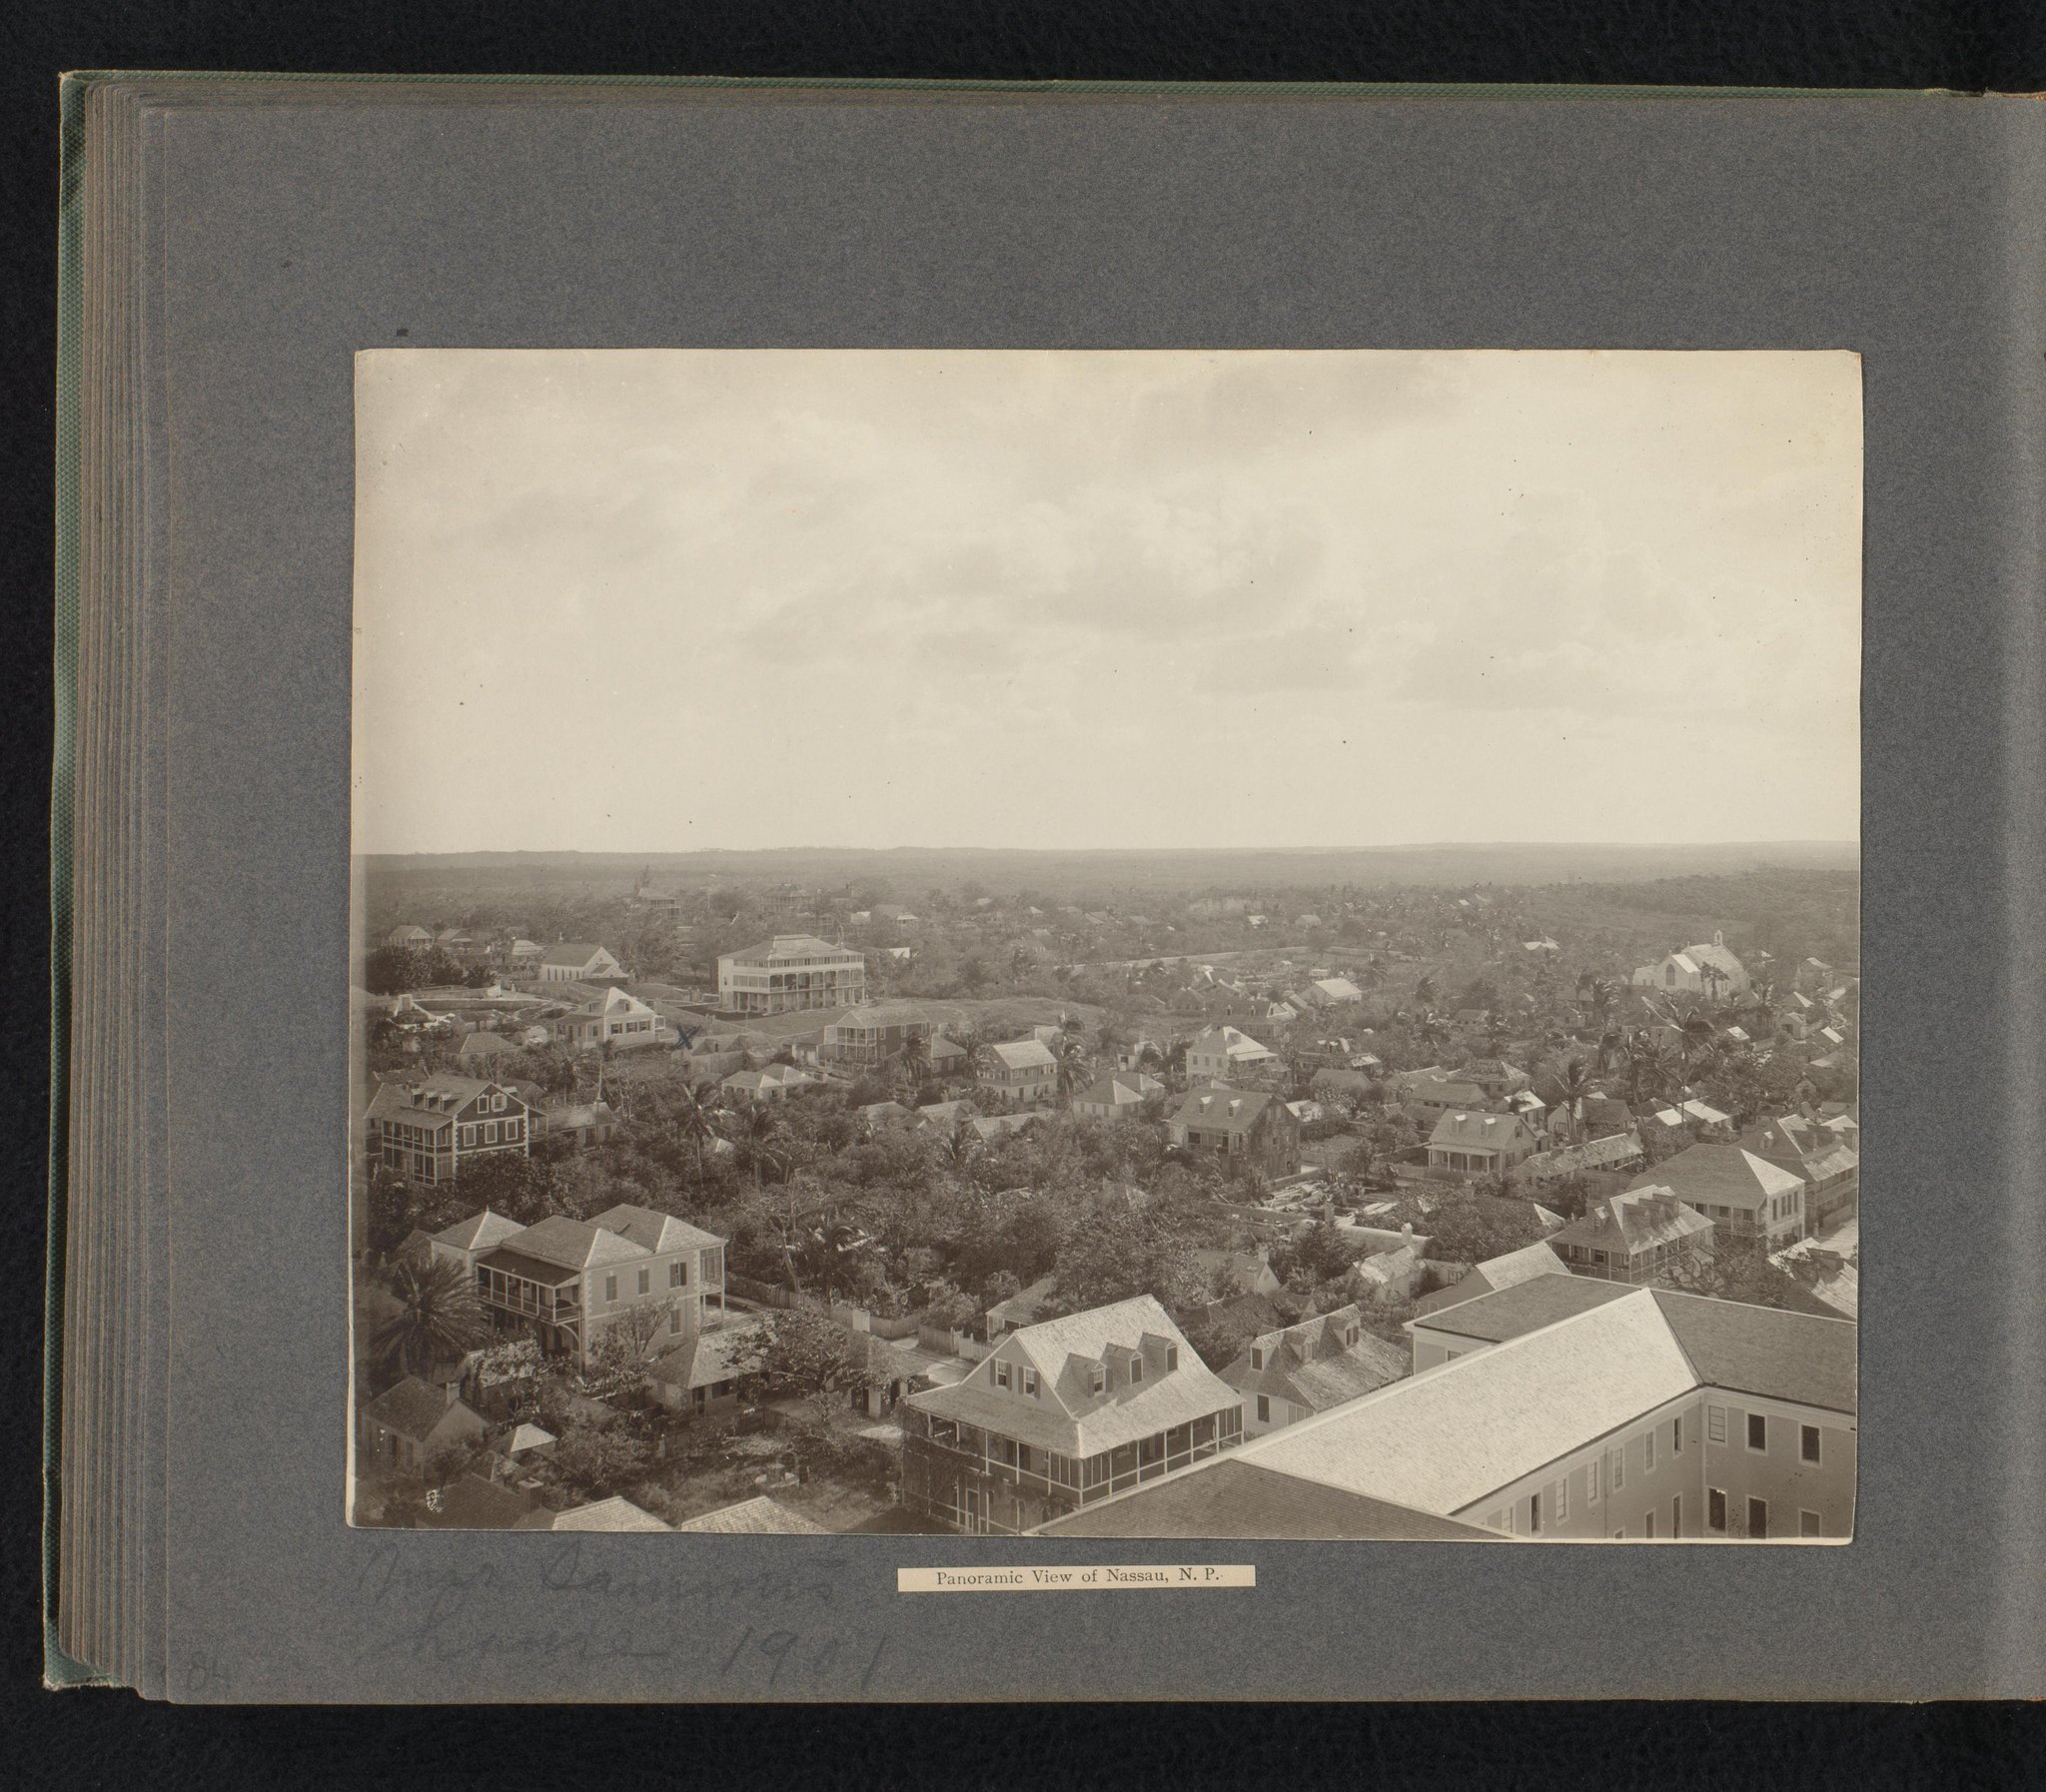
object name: album leaf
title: Gezicht over Nassau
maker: jacob frank coonley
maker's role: fotograaf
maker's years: 1832-1915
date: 1889-1895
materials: paper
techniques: platinum process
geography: nassau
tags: city-view in general; 'veduta'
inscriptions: inscription: ‘Mrs. [...]/ house 1901’